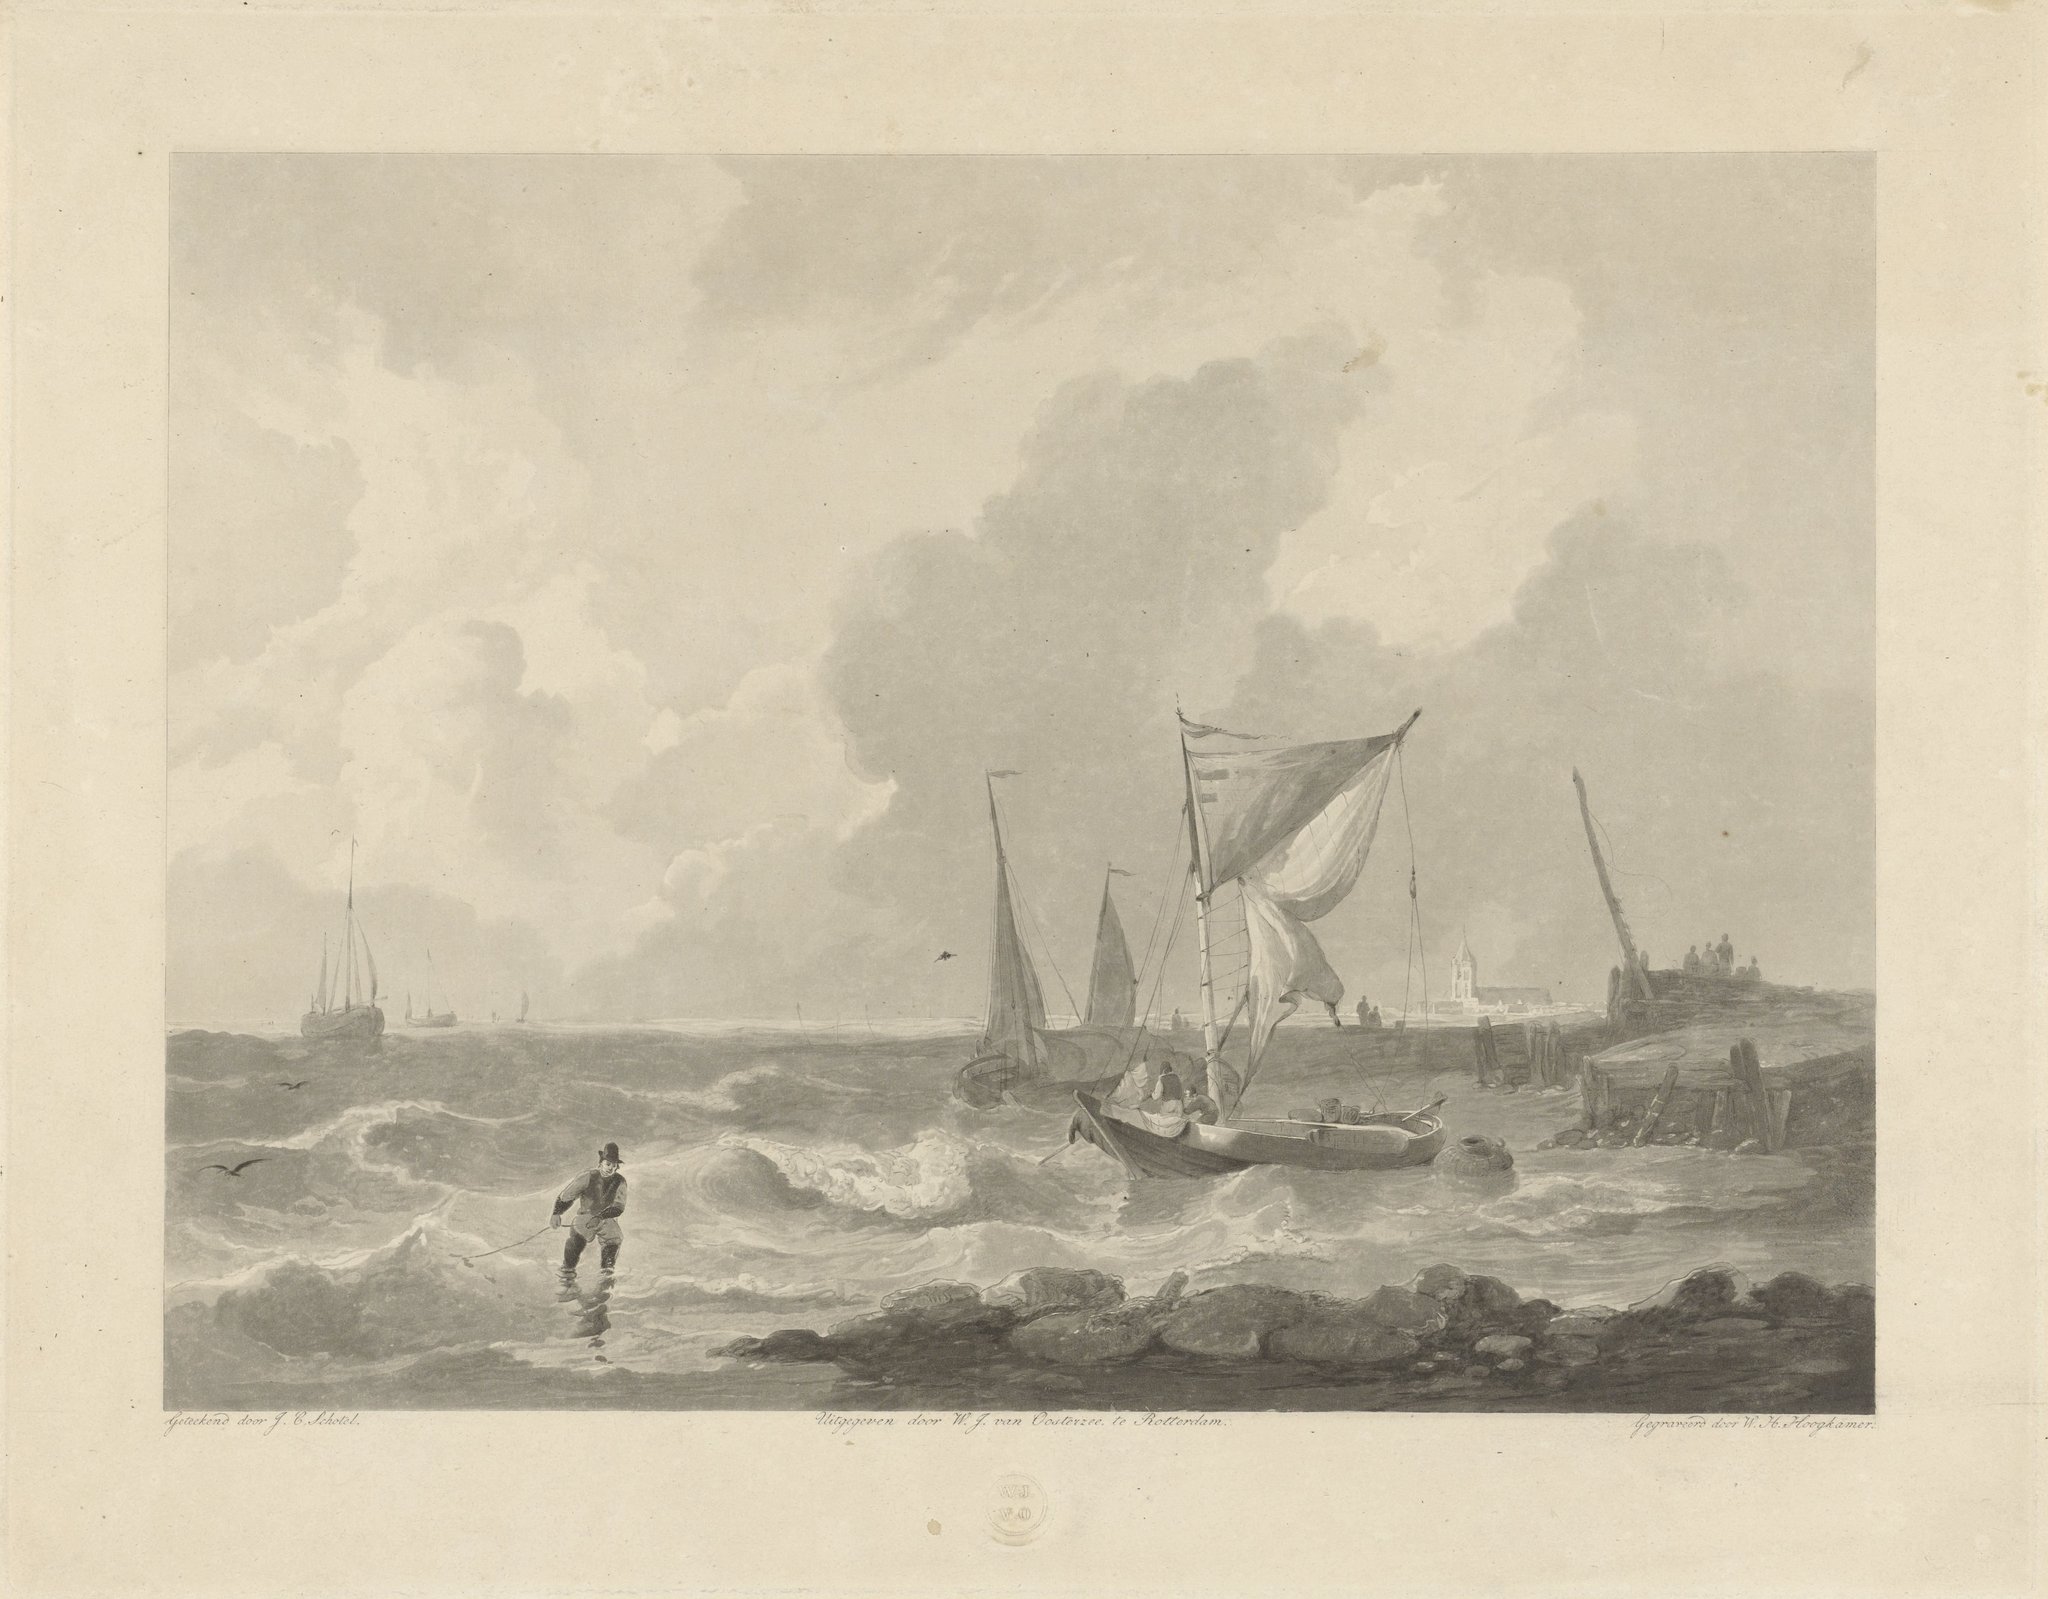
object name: print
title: Vissersboten bij een havenhoofd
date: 1831-1844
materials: paper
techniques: aquatint, etching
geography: netherlands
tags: harbour, sailing-ship, sailing-boat, fisherman, coastal structures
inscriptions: check stamp: ‘W.J.V.O.’, collector's mark: Lugt 2228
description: Twee vissersboten bij een havenhoofd, links op de voorgrond een man in de branding. Een groepje figuren aan de wal, in de verte een kerktoren.